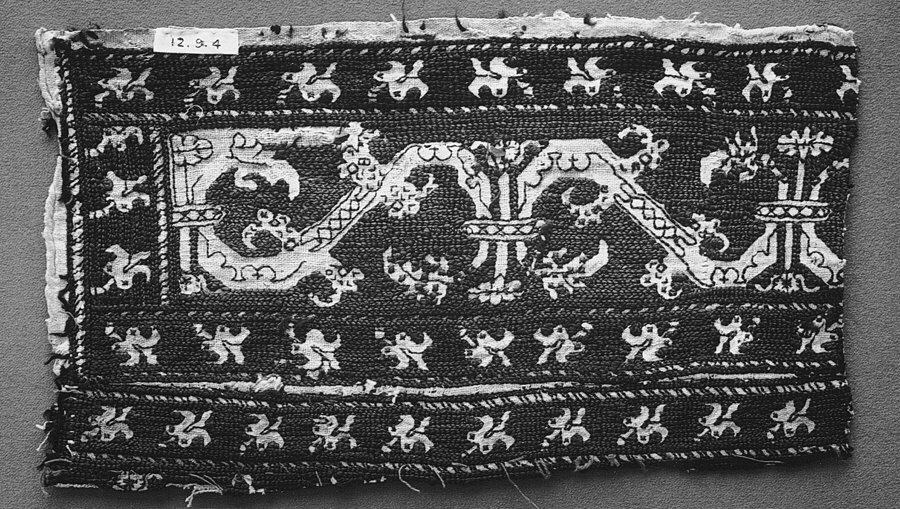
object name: fragment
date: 1601-1700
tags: leaves